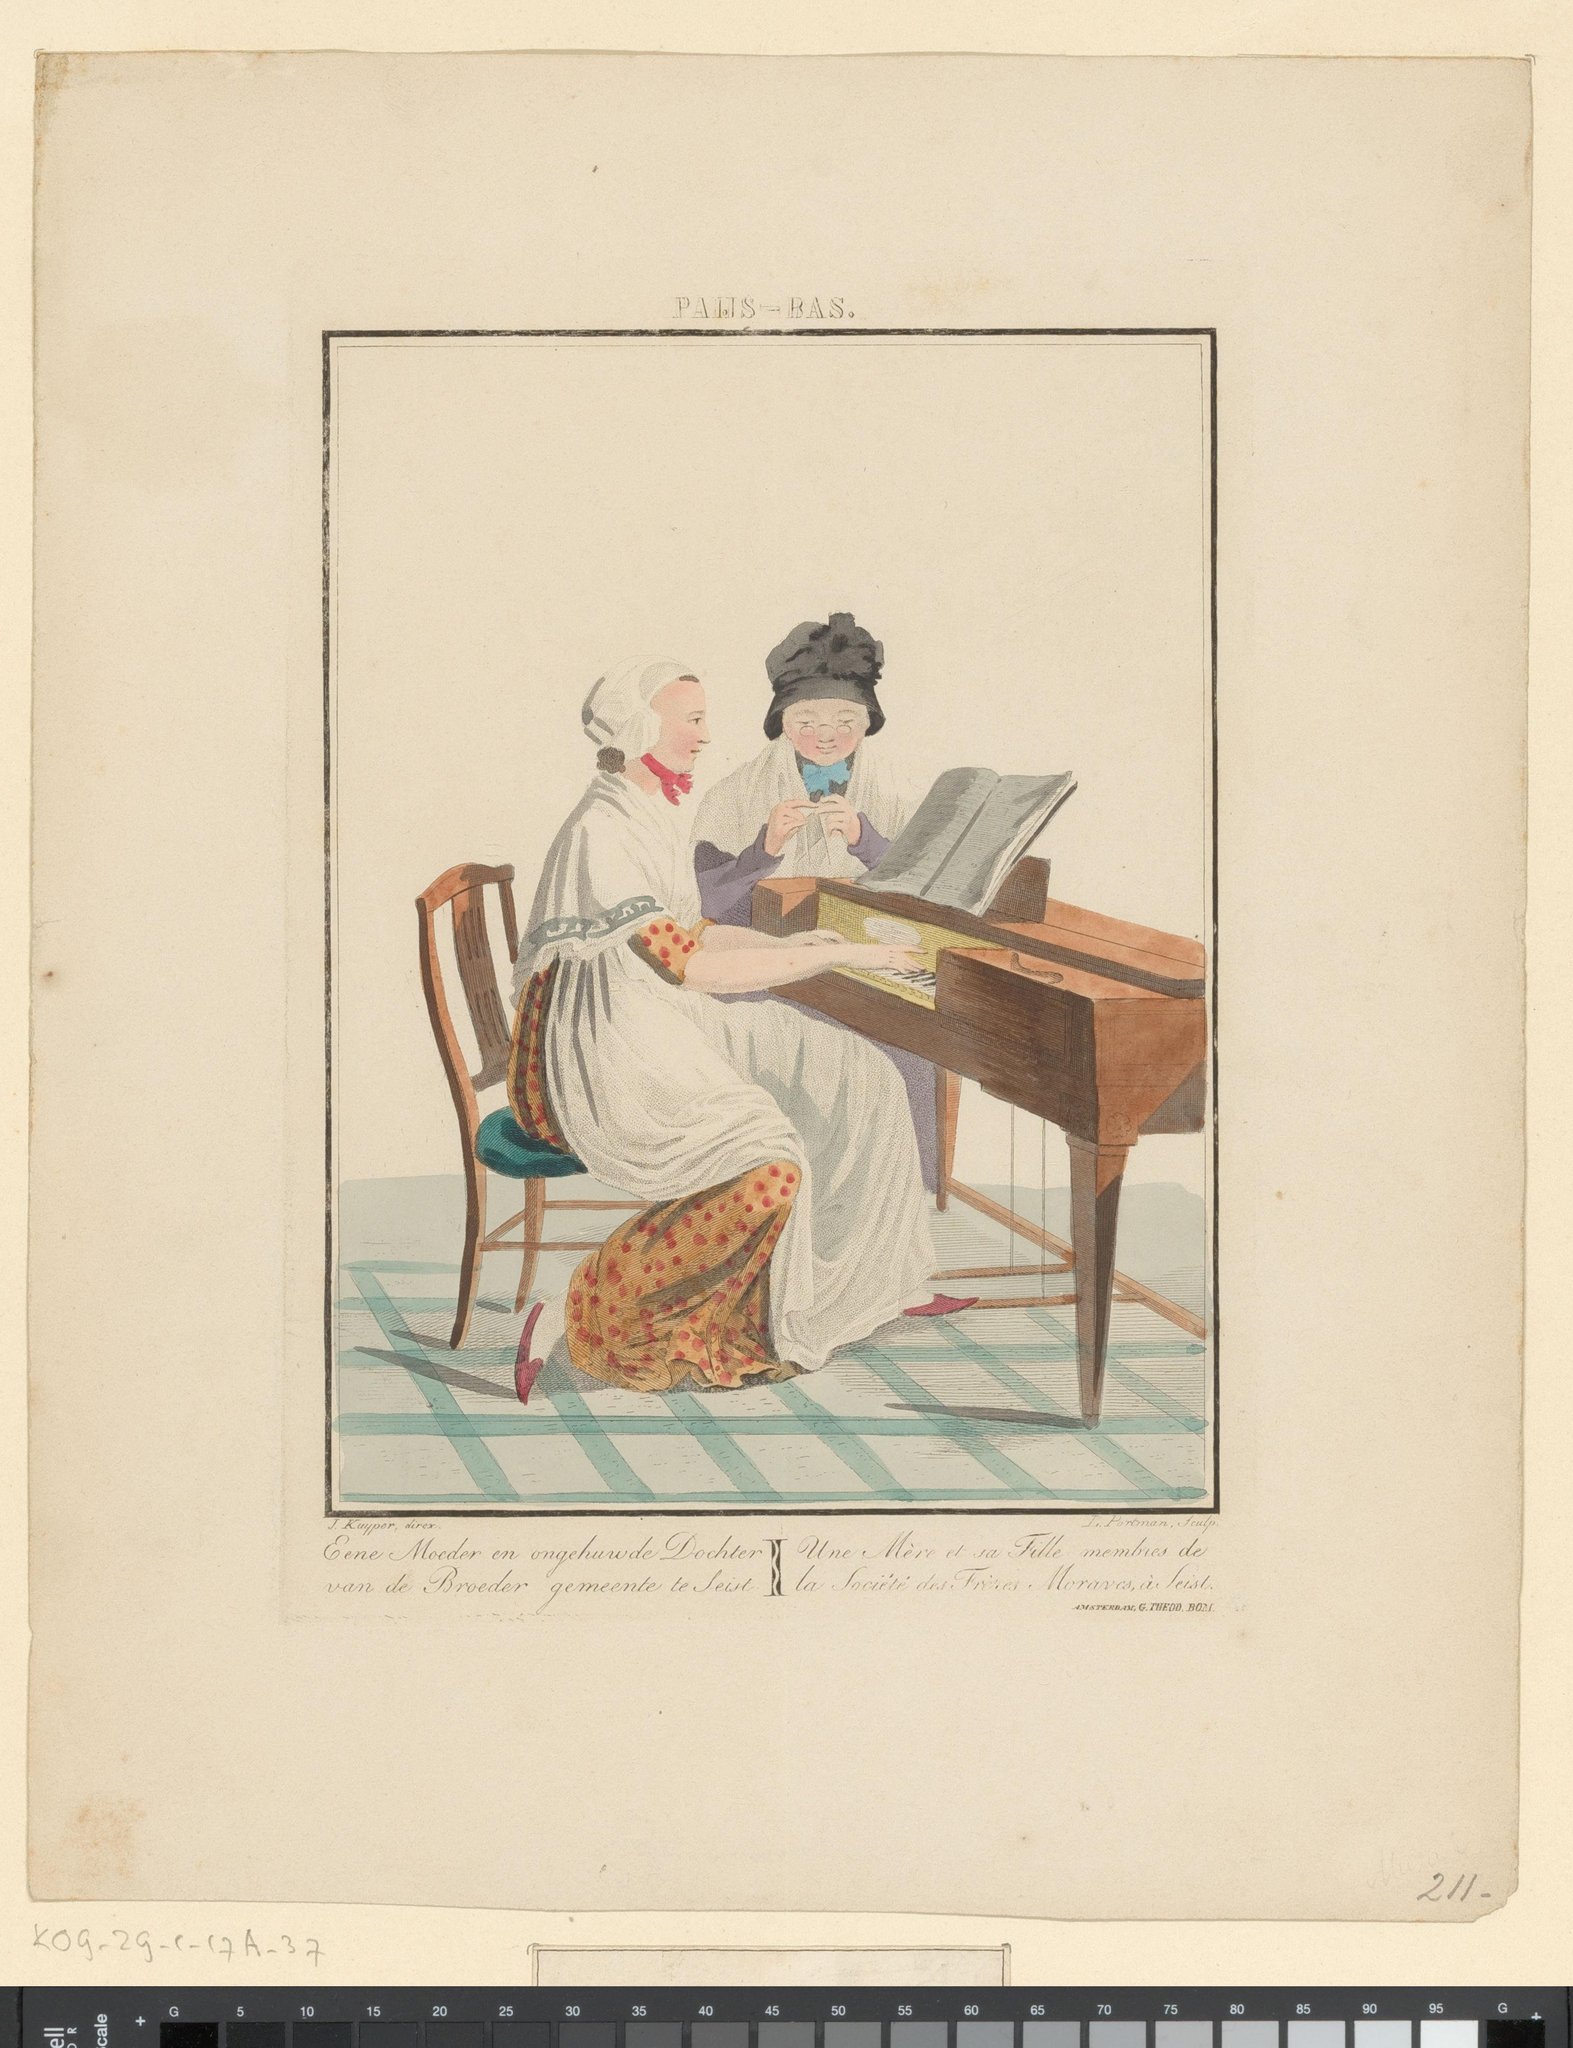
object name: print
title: Paijs-Bas / Eene Moeder en ongehuwde Dochter van de Broeder gemeente te Seist / Une Mère et sa Fille membres de la Société des Frères Moraves à Seist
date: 1840-1851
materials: paper, watercolor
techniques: etching, hand coloring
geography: netherlands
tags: one person playing keyboard instrument, dress, gown (+ women's clothes), clavichord, harpsichord, knitting, zeist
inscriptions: stamp, collector's mark: Lugt 1641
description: Een ongehuwde jongedame speelt op de tafelpiano. Haar moeder zit, breiend, naast haar. Beiden behoren tot de Broedergemeente te Zeist. Onderwerpsrubrieken binnen de Atlas Zeden en Gewoonten: Muziek en muziekinstrumenten: Clavecimbaal en zang.